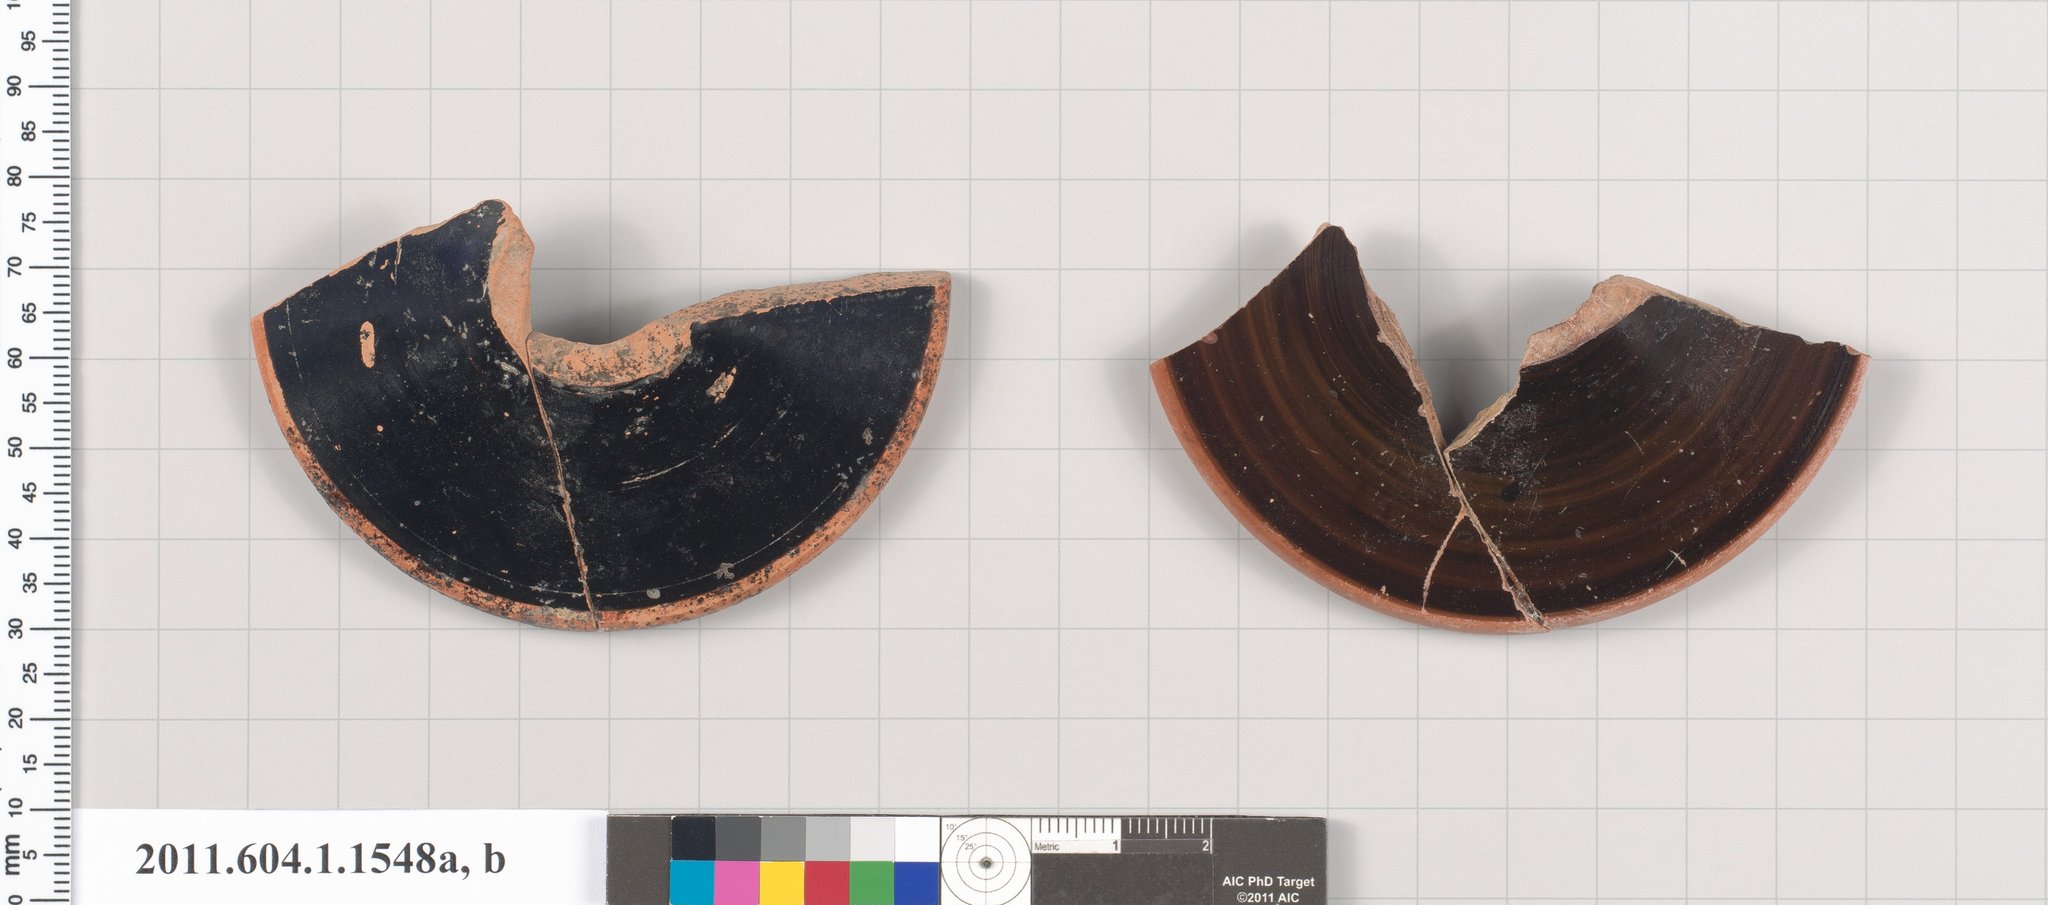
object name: kylix fragment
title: Terracotta fragments of kylikes (drinking cups)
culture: greek, attic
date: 500-401 BCE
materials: terracotta